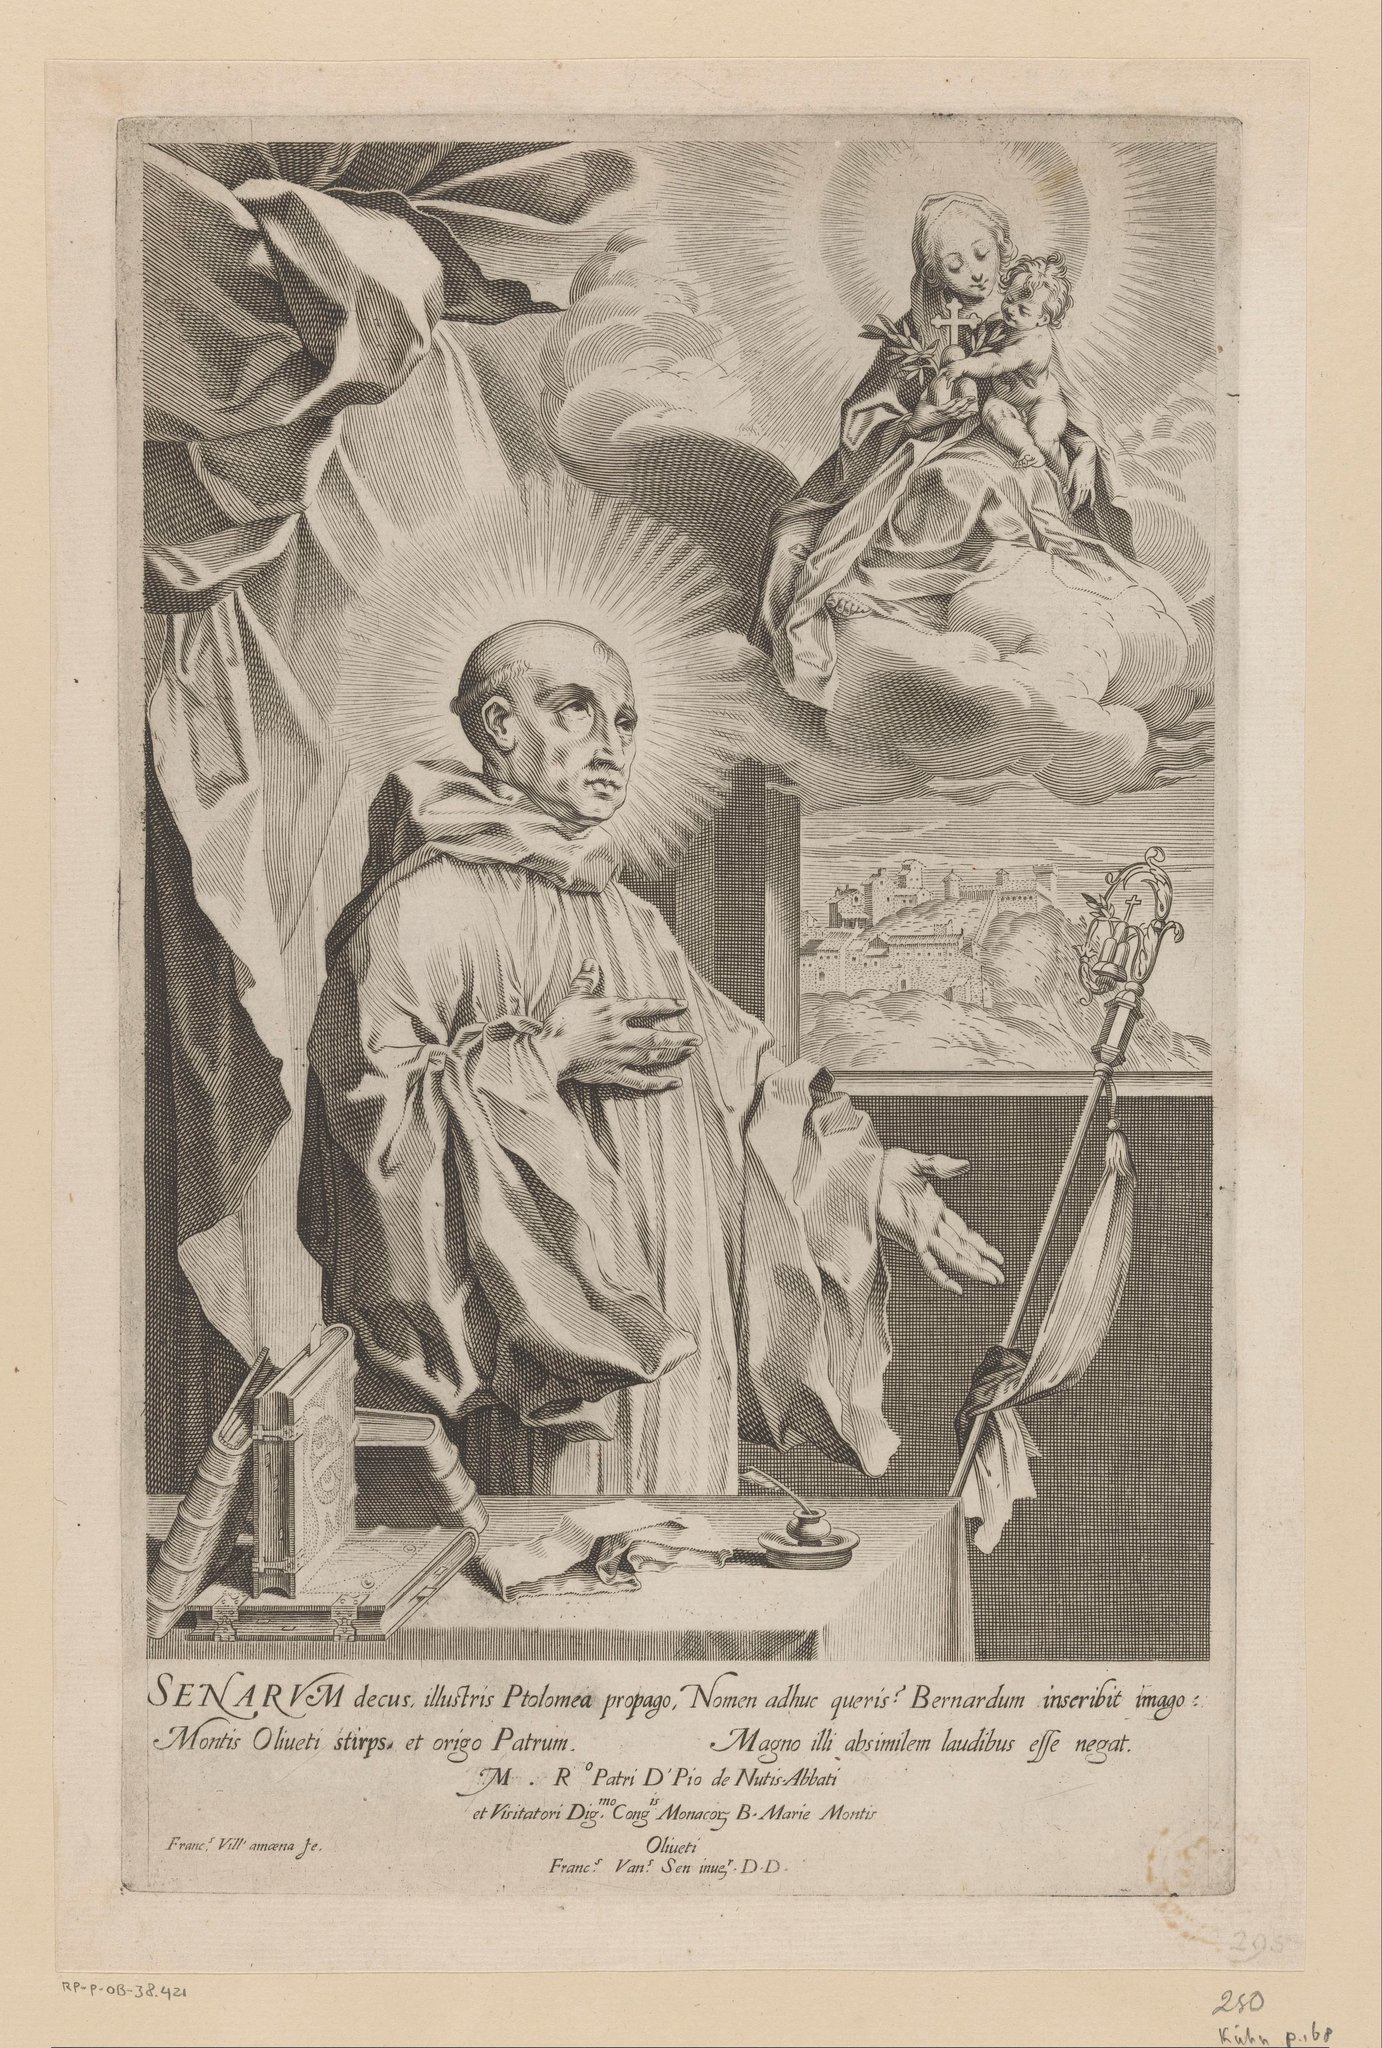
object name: print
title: Heilige Bernardus Tolomei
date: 1576-1624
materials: paper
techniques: engraving, intaglio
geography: italy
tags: madonna accompanied by saint(s)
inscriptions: collector's mark: Lugt 240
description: De heilige Bernardus Tolomei, stichter van de orde van de Olivetanen. In de lucht Maria met het Christuskind op een wolkenpartij. In haar hand draagt Maria het symbool van de Olivetanen. Rechts een doorkijk naar het klooster op Monte Oliveto. Opdracht en Latijnse tekst in ondermarge.